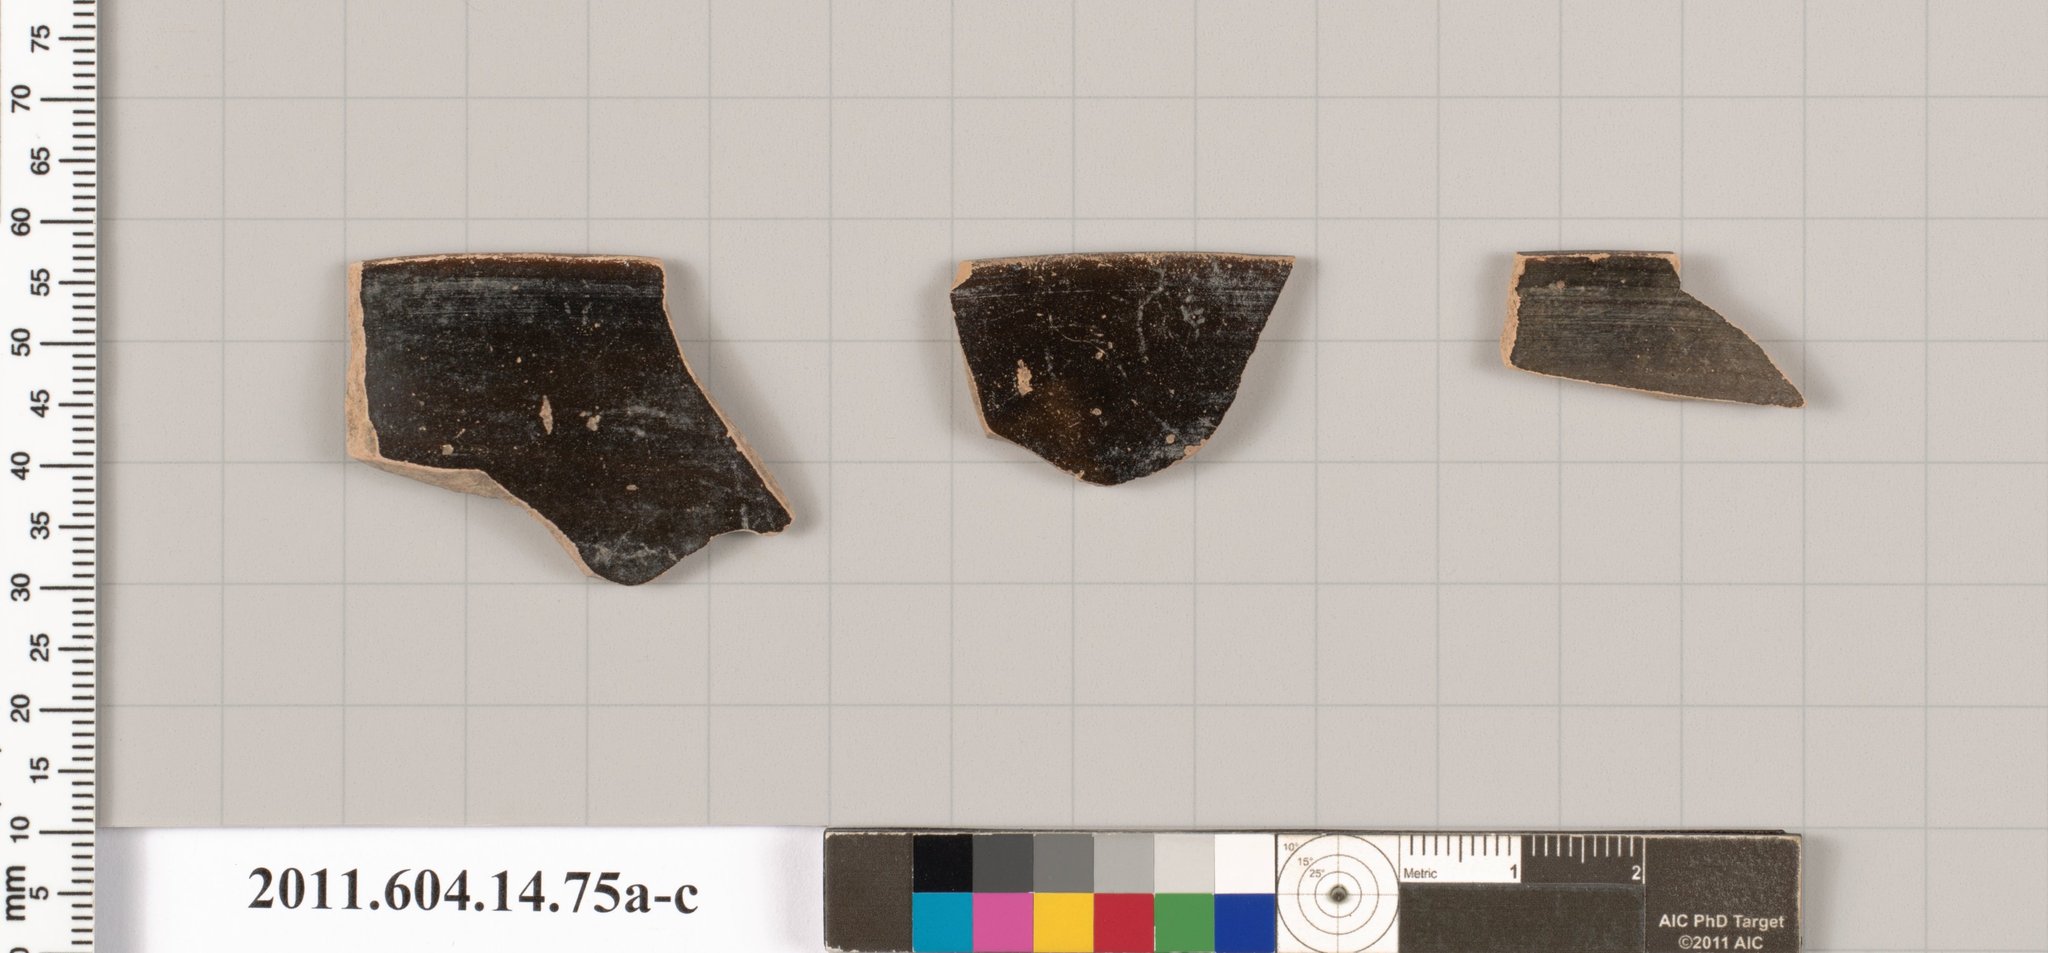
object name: kylix fragment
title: Terracotta rim fragments of kylikes (drinking cups)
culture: unknown fabric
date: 600-301 BCE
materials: terracotta